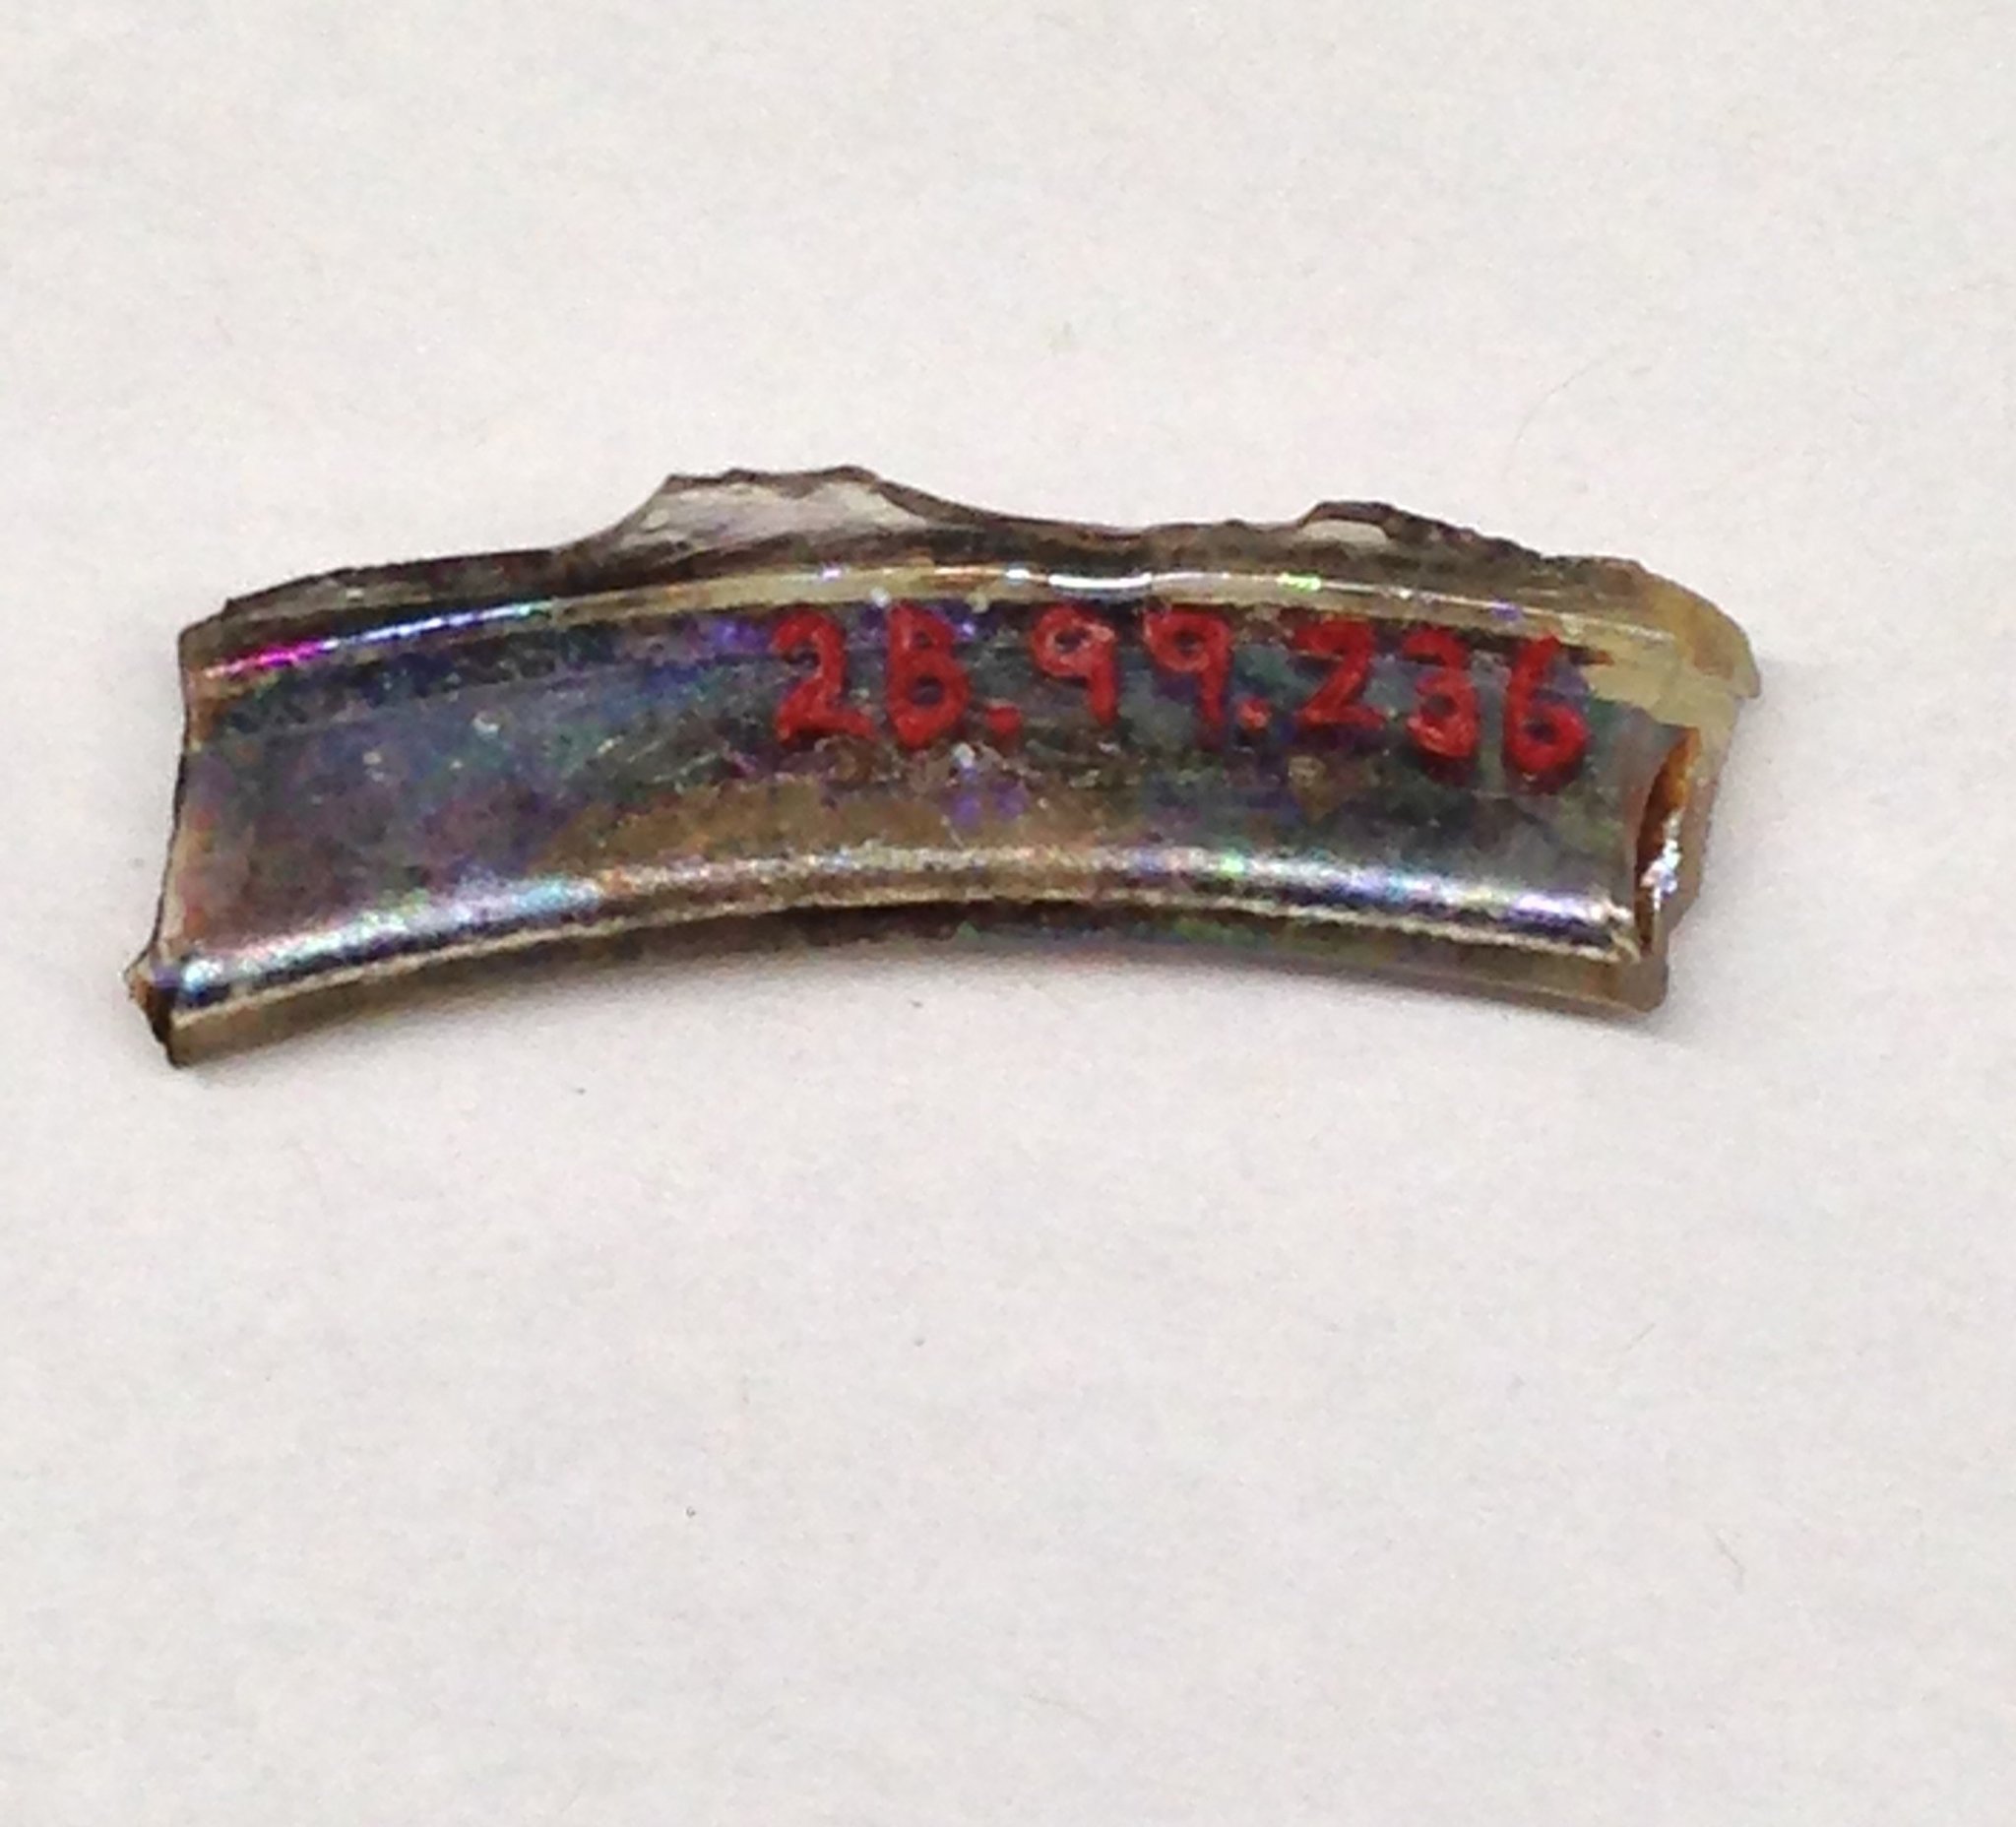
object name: fragment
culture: european or middle eastern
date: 1150-1250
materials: ceramic, glass